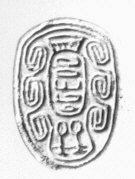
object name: stamp seal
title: Scarab seal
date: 1786-1560 BCE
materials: stone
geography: levant